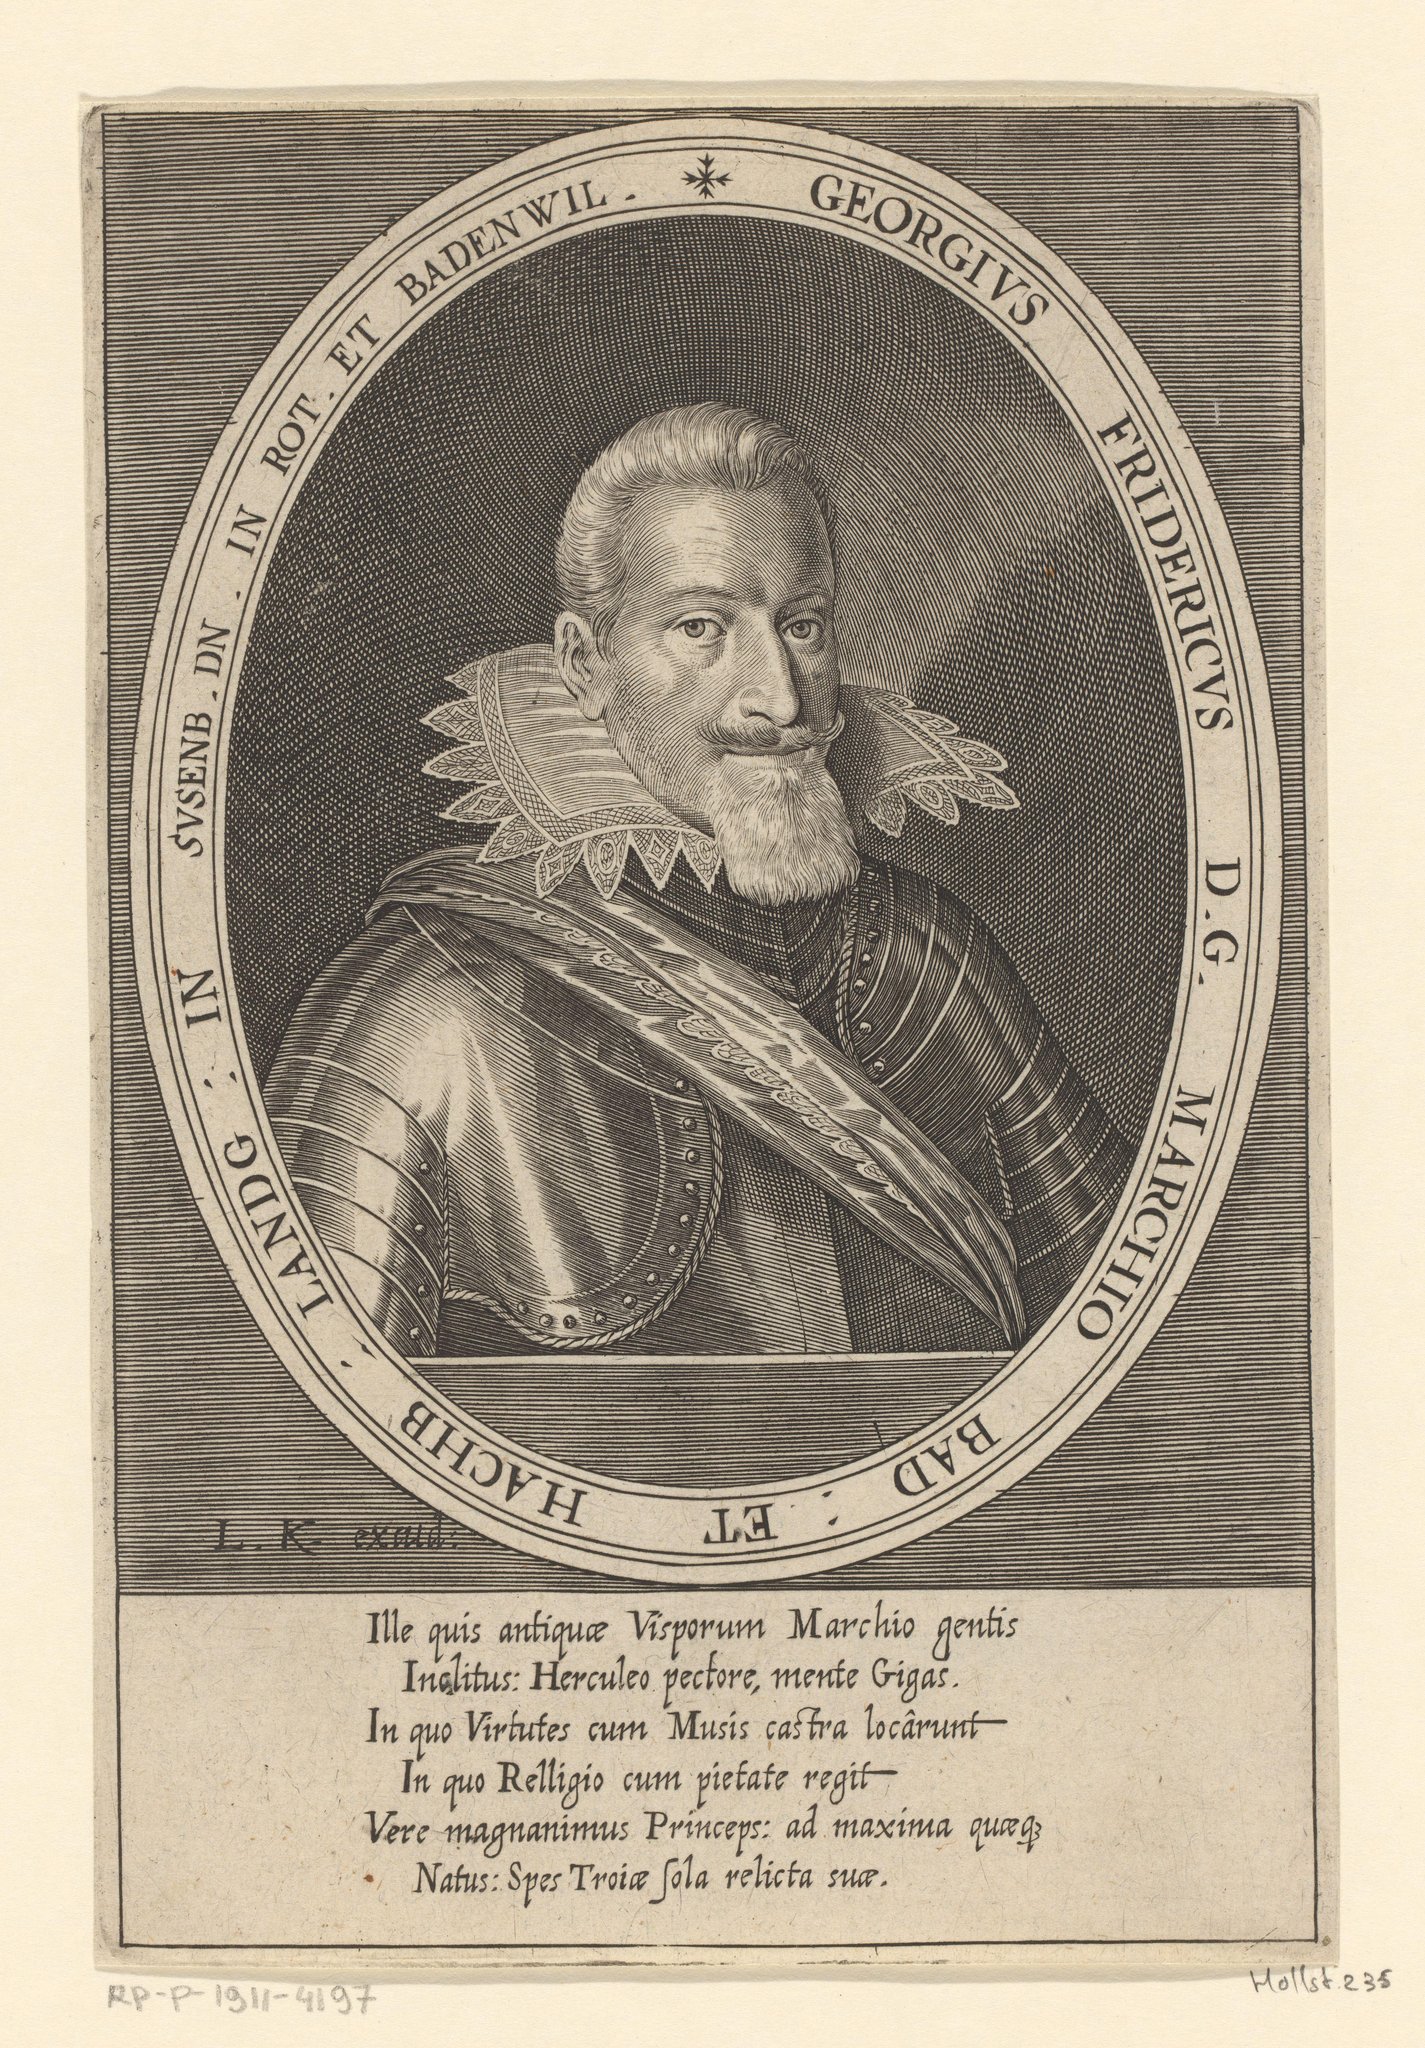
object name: print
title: Portret van Georg Friedrich von Baden-Durlach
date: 1589-1637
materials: paper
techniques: engraving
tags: historical persons, officer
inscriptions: collector's mark: Lugt 2228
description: Tekst in het Latijn in de omlijsting en in de ondermarge.